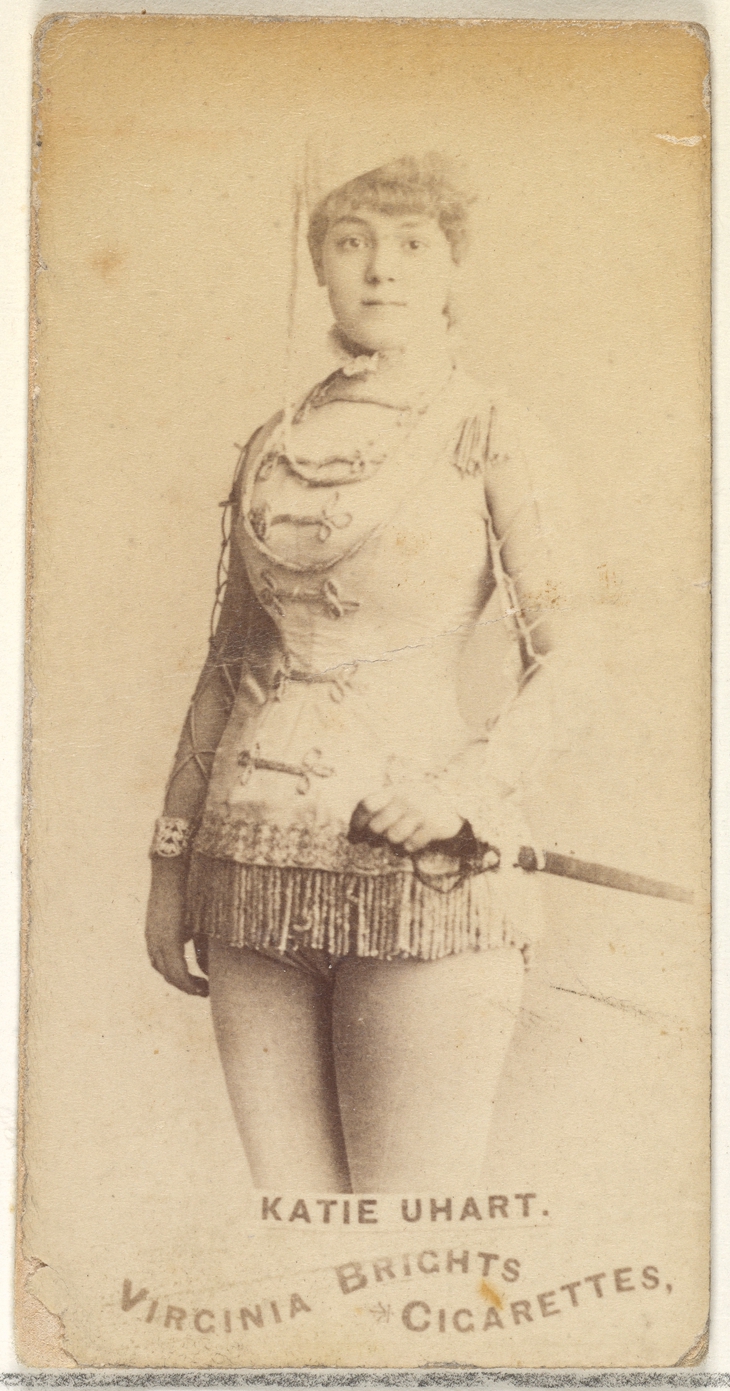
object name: photograph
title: Katie Uhart, from the Actors and Actresses series (N45, Type 1) for Virginia Brights Cigarettes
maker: allen & ginter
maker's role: publisher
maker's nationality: american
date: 1888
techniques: albumen silver print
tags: portraits,women,actresses